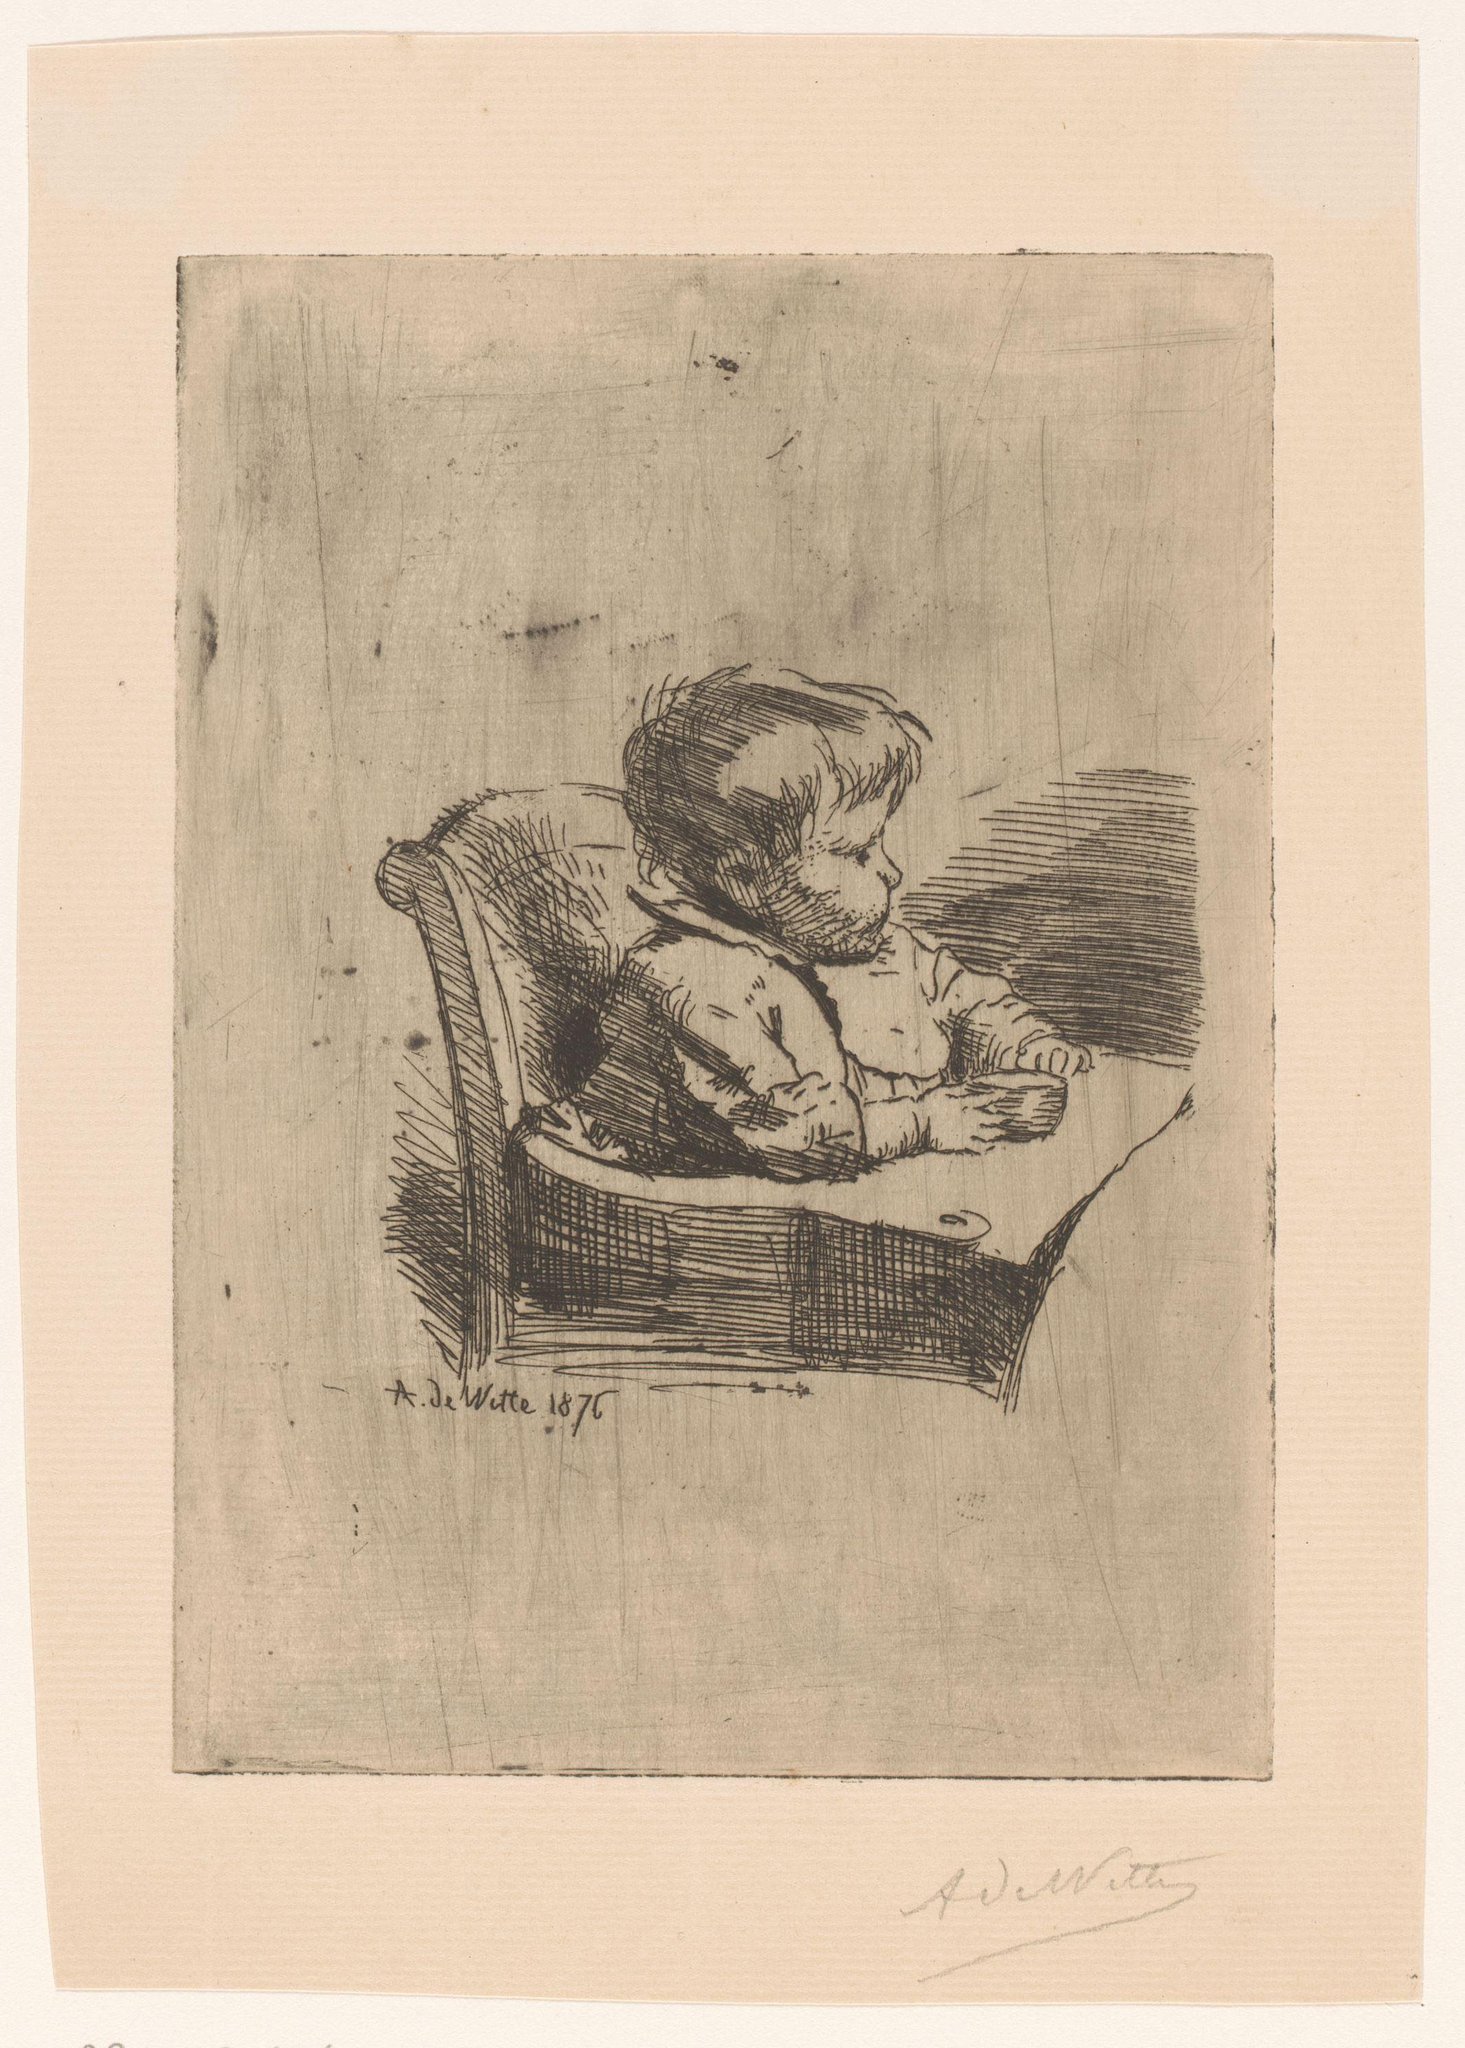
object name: print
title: Kind gezeten in een kinderstoel, mogelijk Jacques Bernimolin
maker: adrien de witte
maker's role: print maker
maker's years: 1850-1935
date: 1876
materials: paper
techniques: etching, intaglio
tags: baby-chair, child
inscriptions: collector's mark: Lugt 2228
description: Mogelijk portret van de neef van Adrien de Witte: Jacques Bernimolin.